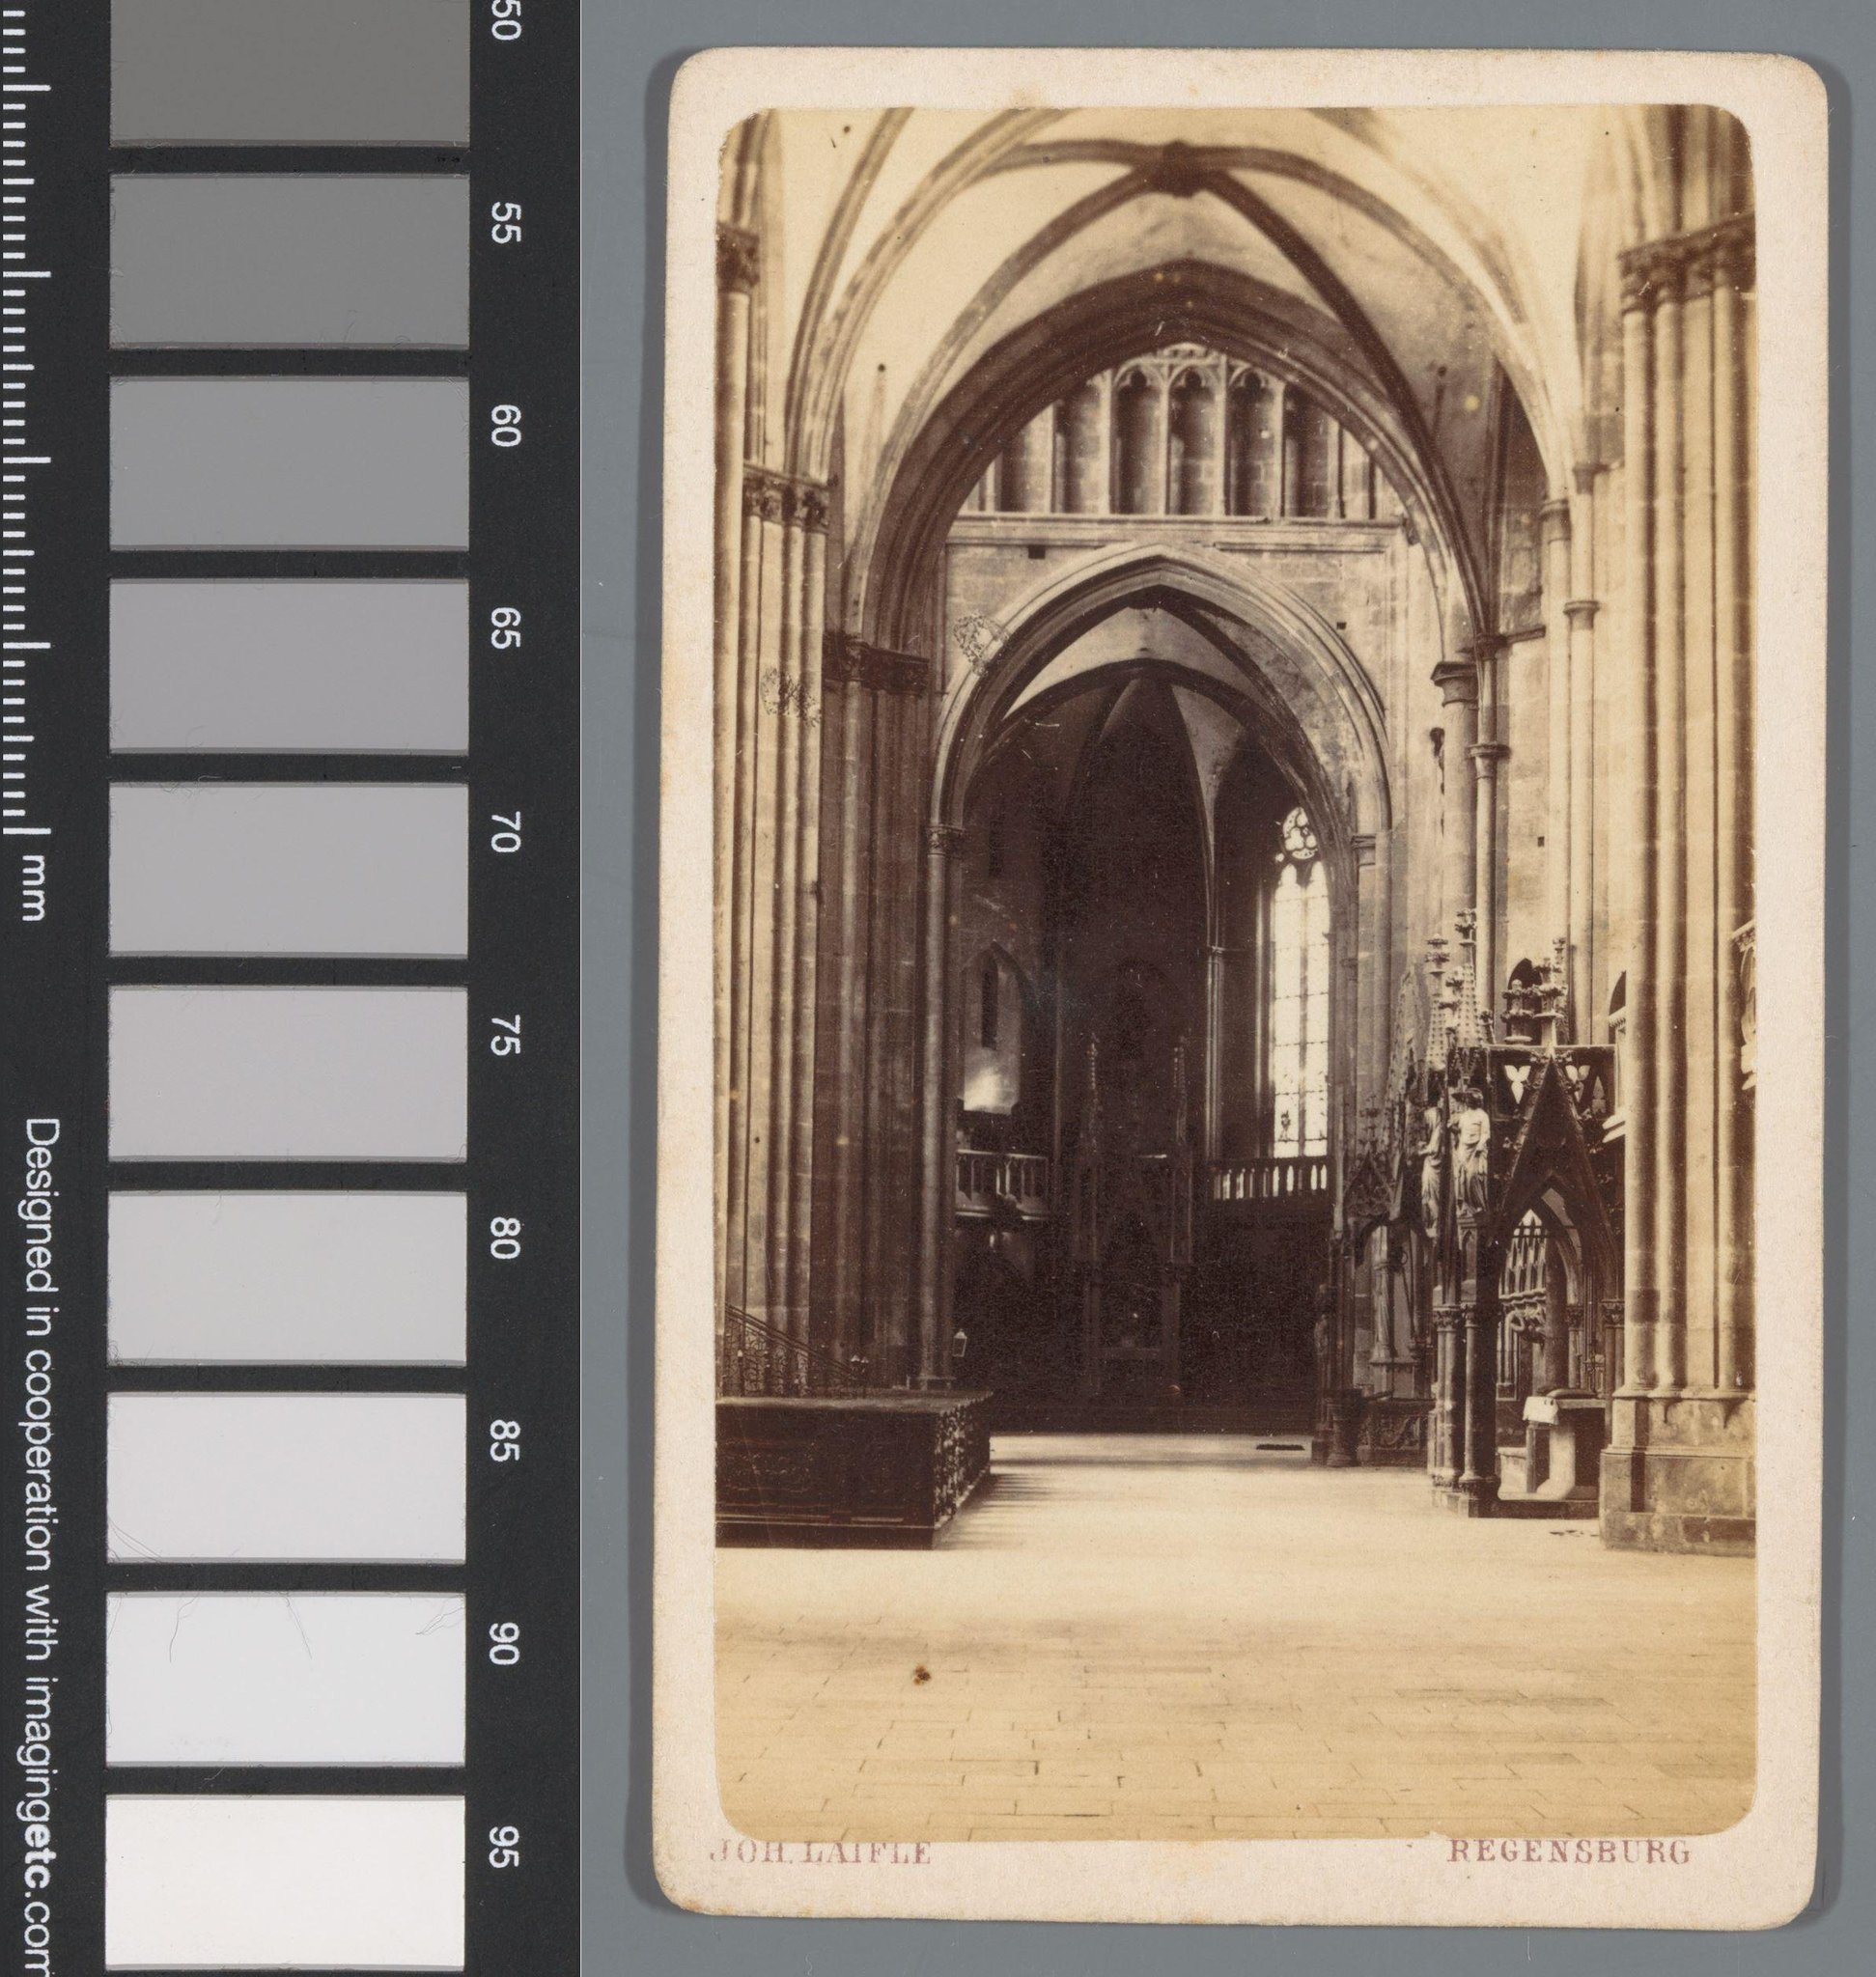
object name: carte de visite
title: Zijkapel v/d Dom Regensburg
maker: johann laifle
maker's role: fotograaf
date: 1855-1885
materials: cardboard, paper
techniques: albumen print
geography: regensburg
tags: parts of church interior: chapel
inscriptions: inscription: ‘JOH LAIFLE/ Photographisches Atelier/ REGENSBURG.’